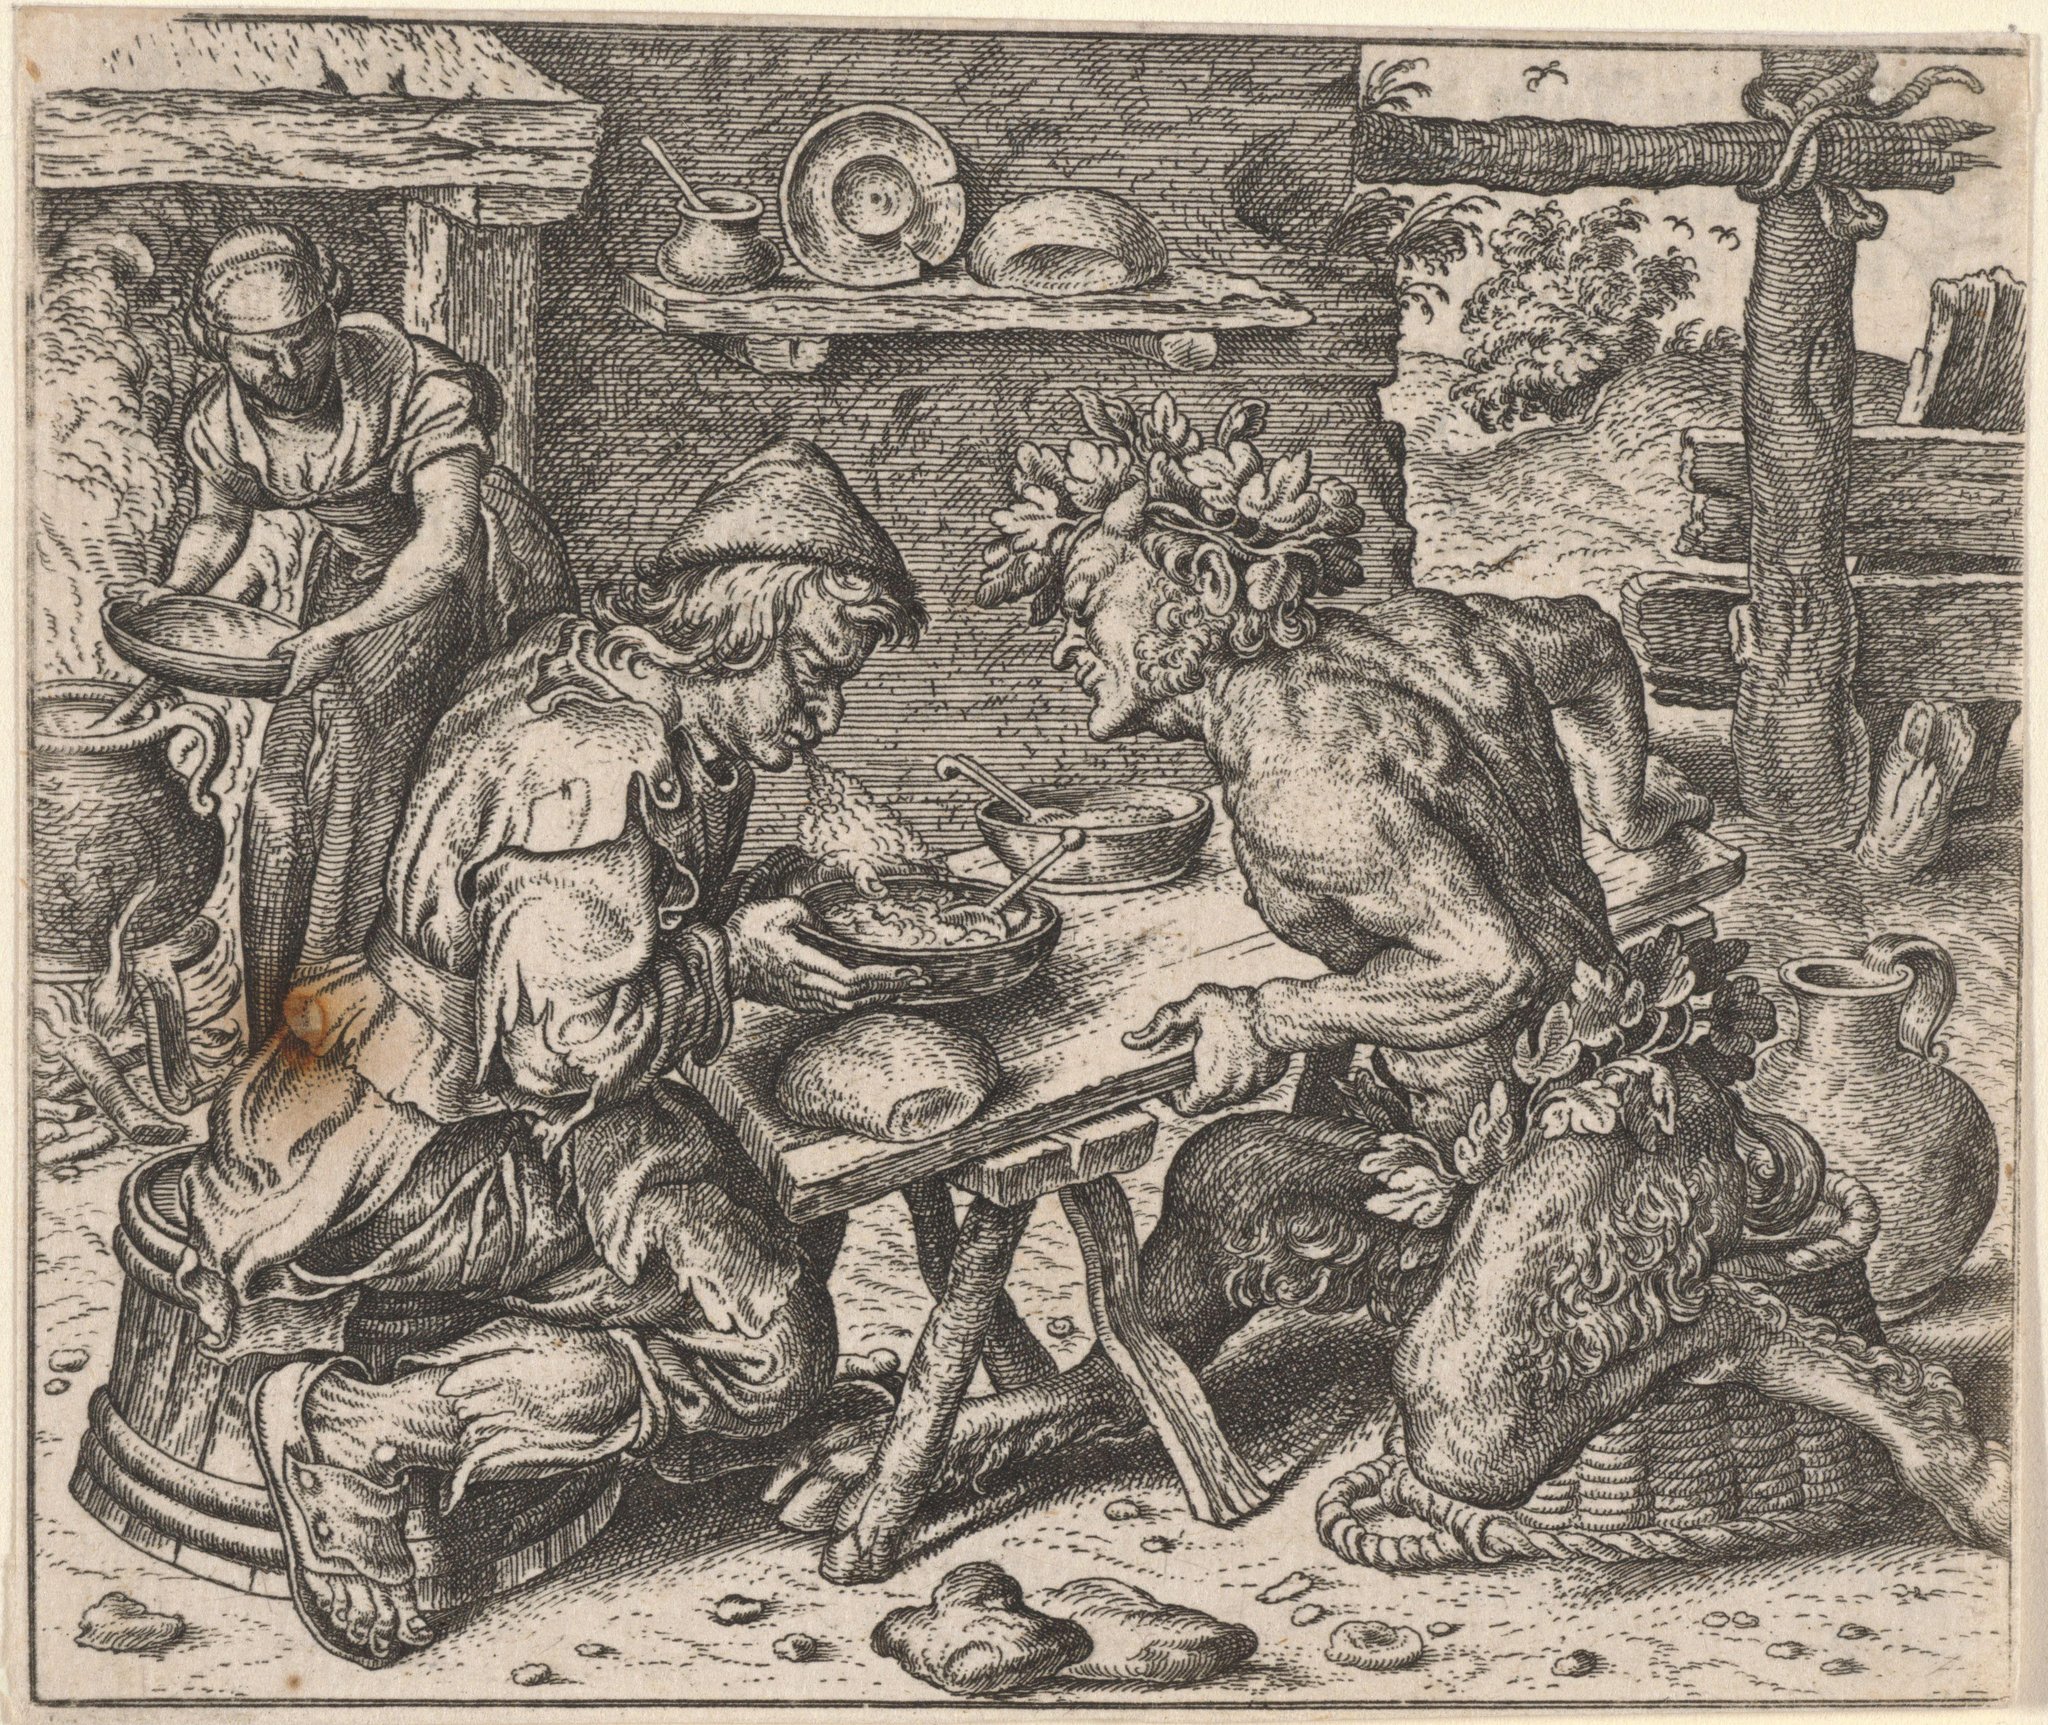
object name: print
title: Fabel van de boer en de sater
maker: aegidius sadeler (ii)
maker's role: draughtsman, print maker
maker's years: 1568-1629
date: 1608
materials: paper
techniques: engraving, etching, letterpress printing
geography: prague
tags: the satyr and the peasants; according to aesop: the satyrs and the peasant (meal, blowing to cool food, etc.)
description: Een boer en een sater aan een tafel in een huis. De sater kijkt geboeid naar de boer die in zijn soep blaast. De fabel beschrijft hoe een sater te gast is bij een boer. De boer blaast eerst in zijn verkleumde handen en daarna in zijn kom soep. De sater is verbaasd dat de boer uit eigen mond zowel warmte als kou kan blazen en beschouwt hem als een tovenaar.